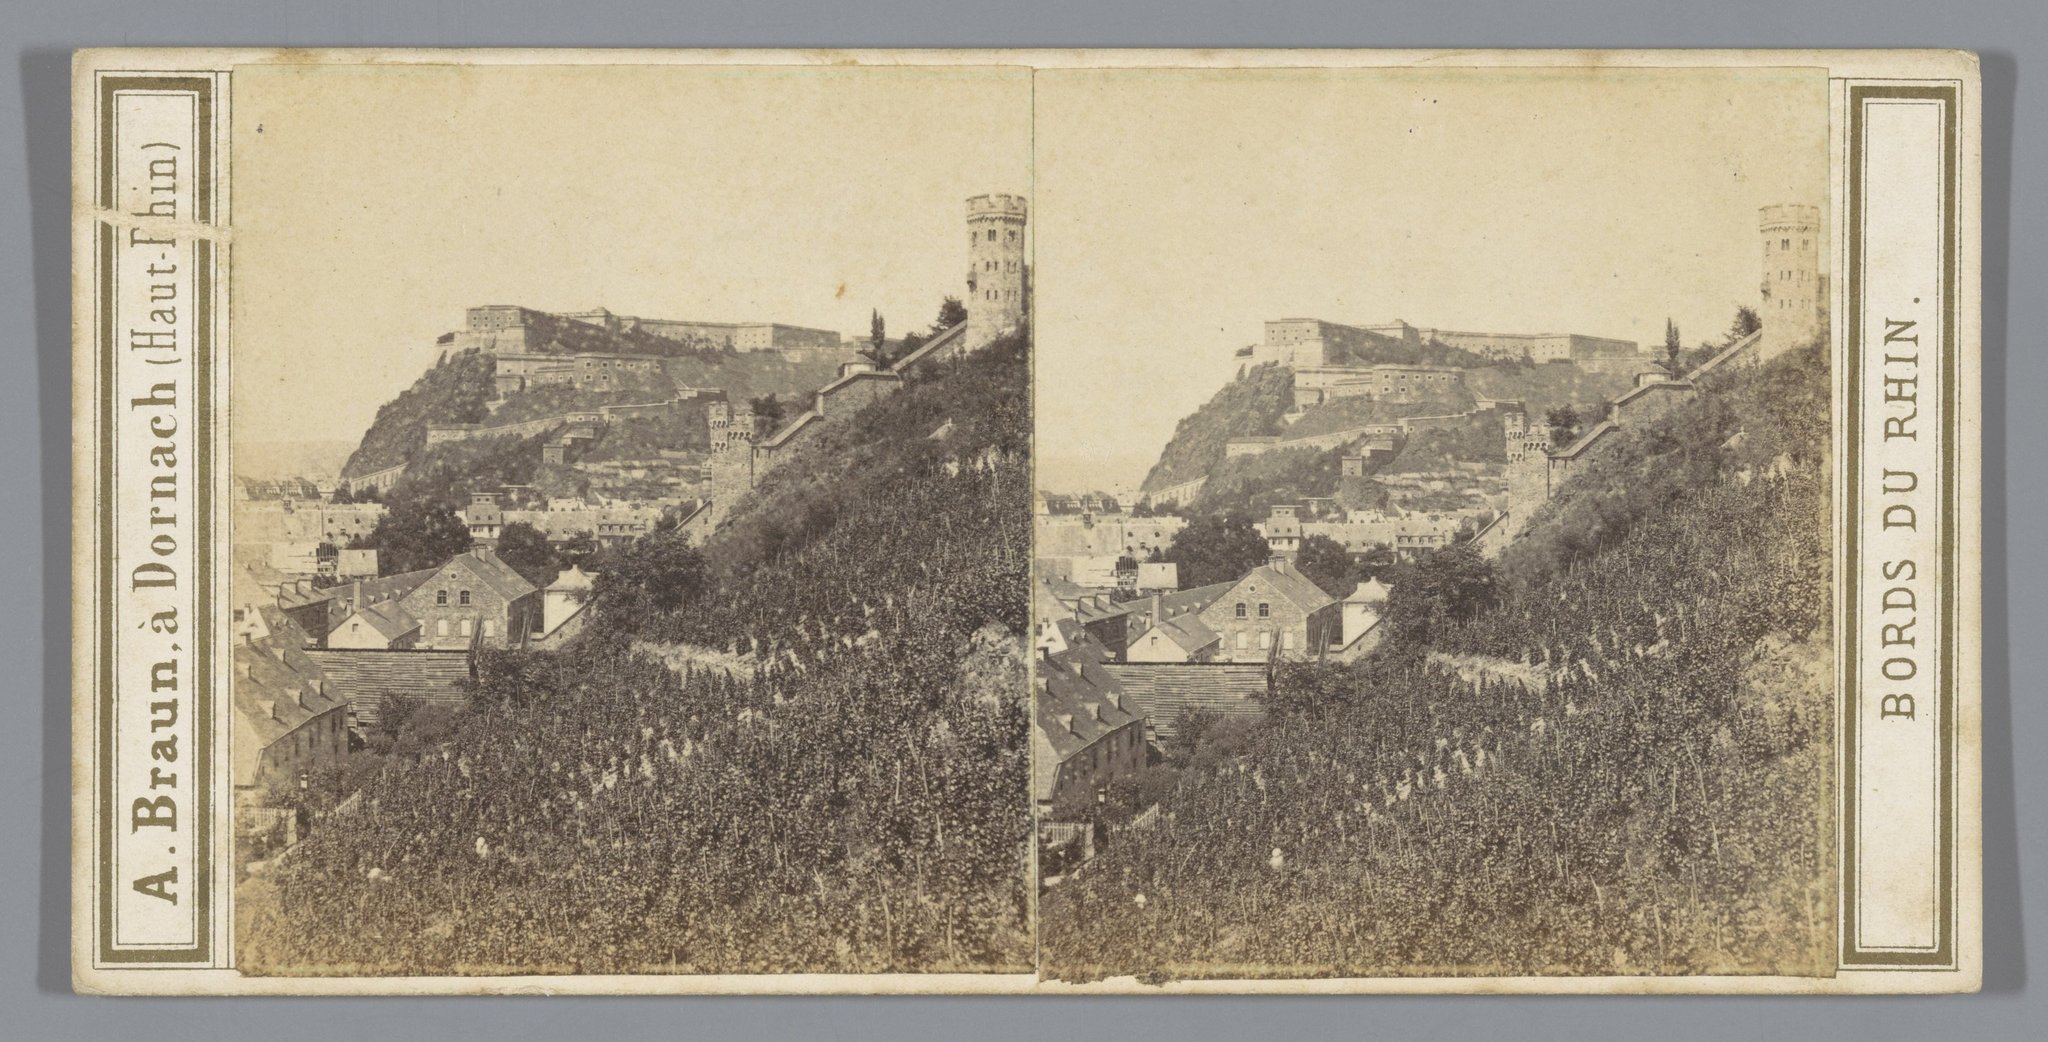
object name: stereograph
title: Fortifications d'Ehrenbreitstein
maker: Anonymous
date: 1860-1866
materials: cardboard, paper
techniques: albumen print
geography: koblenz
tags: landscape with tower or castle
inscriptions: number: ‘No 2669.’